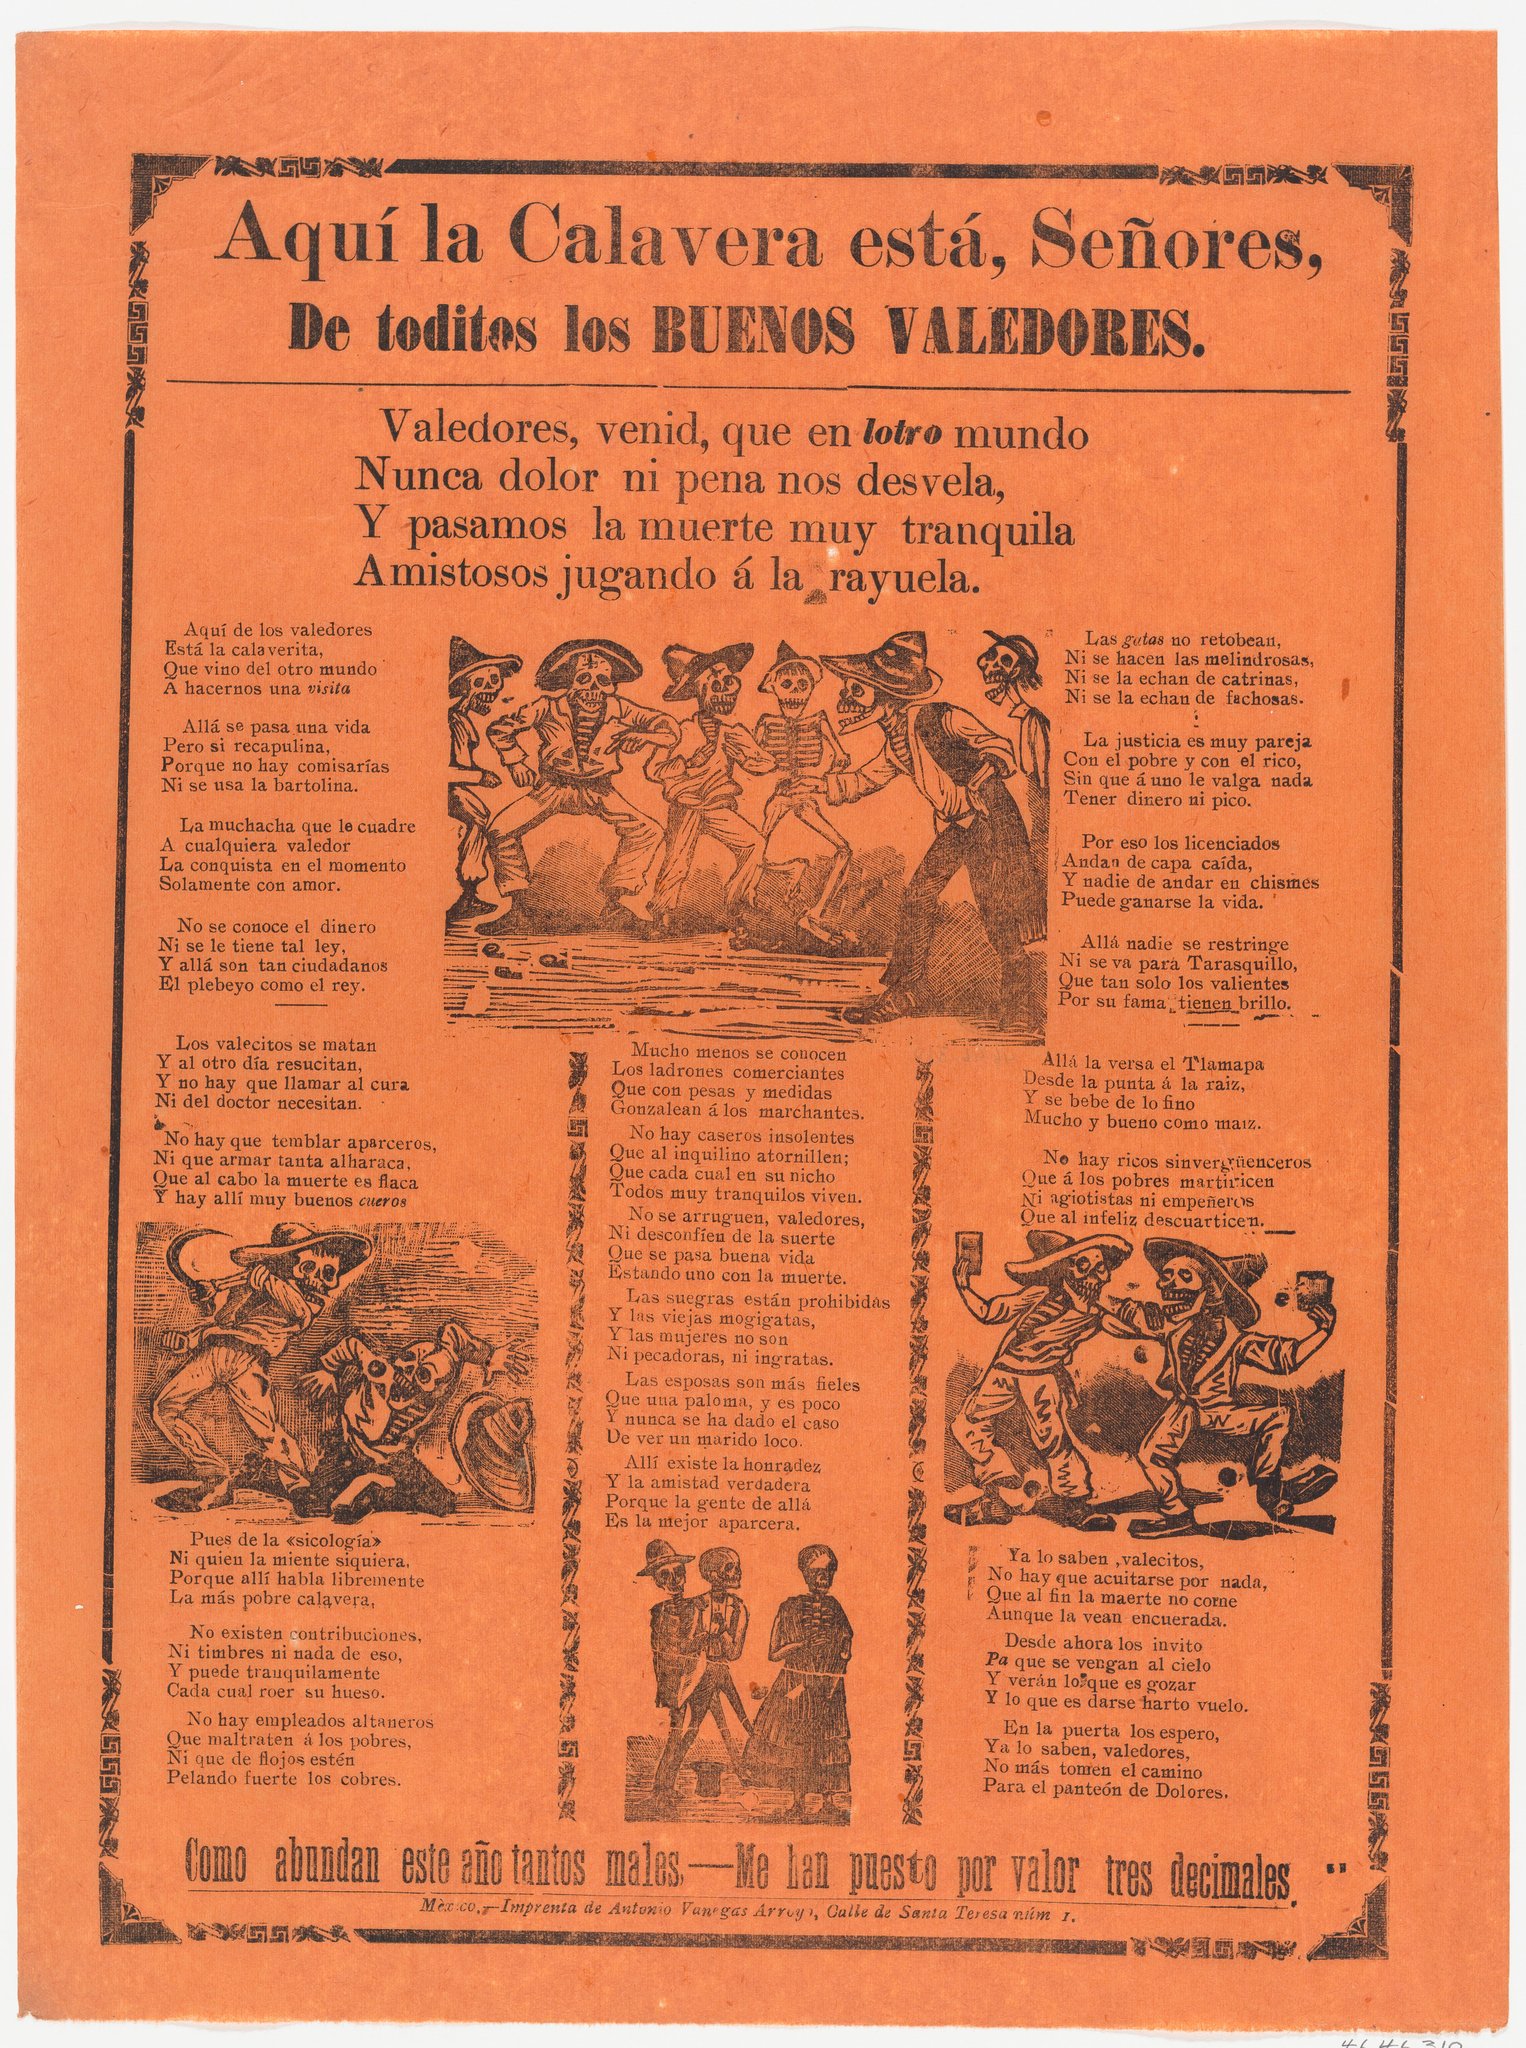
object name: print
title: Skeletons of the good defenders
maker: josé guadalupe posada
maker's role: artist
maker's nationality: mexican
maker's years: 1852-1913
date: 1900-1910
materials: metal, paper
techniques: engraving, letterpress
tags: skeletons,dancing